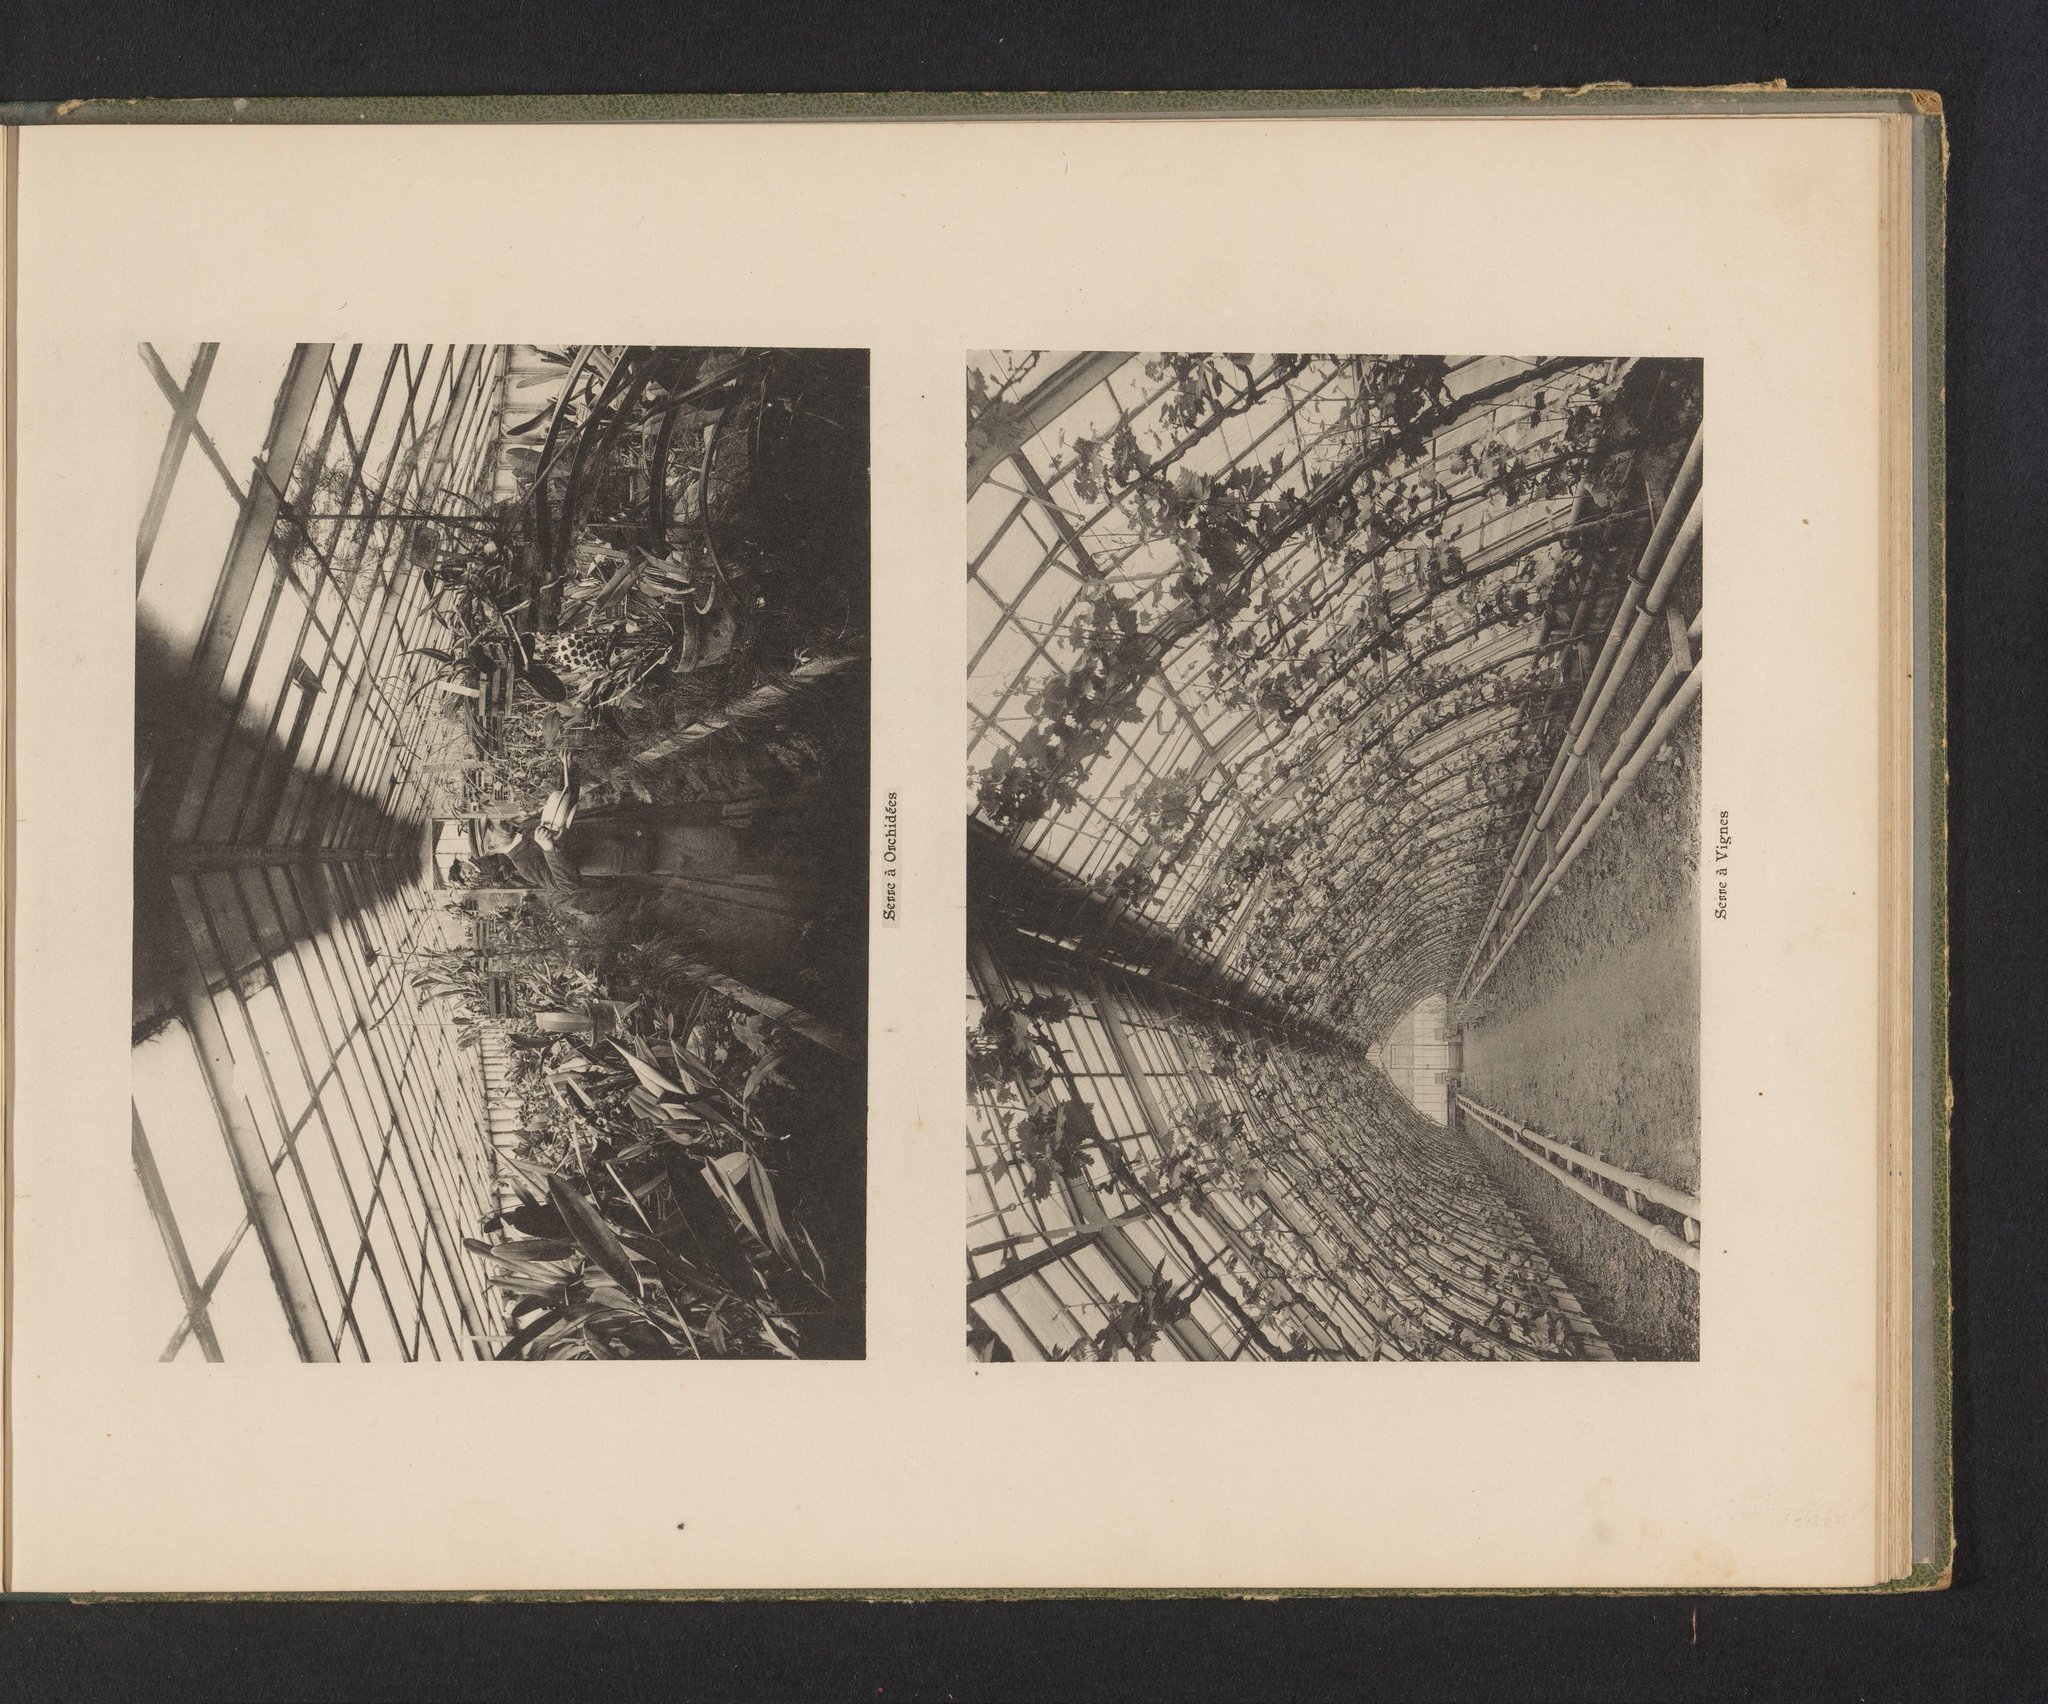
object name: photomechanical print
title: Serre à Orchidées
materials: paper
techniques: photograph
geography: versailles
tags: horticulture, vegetable culture, market gardening, greenhouse, orangery